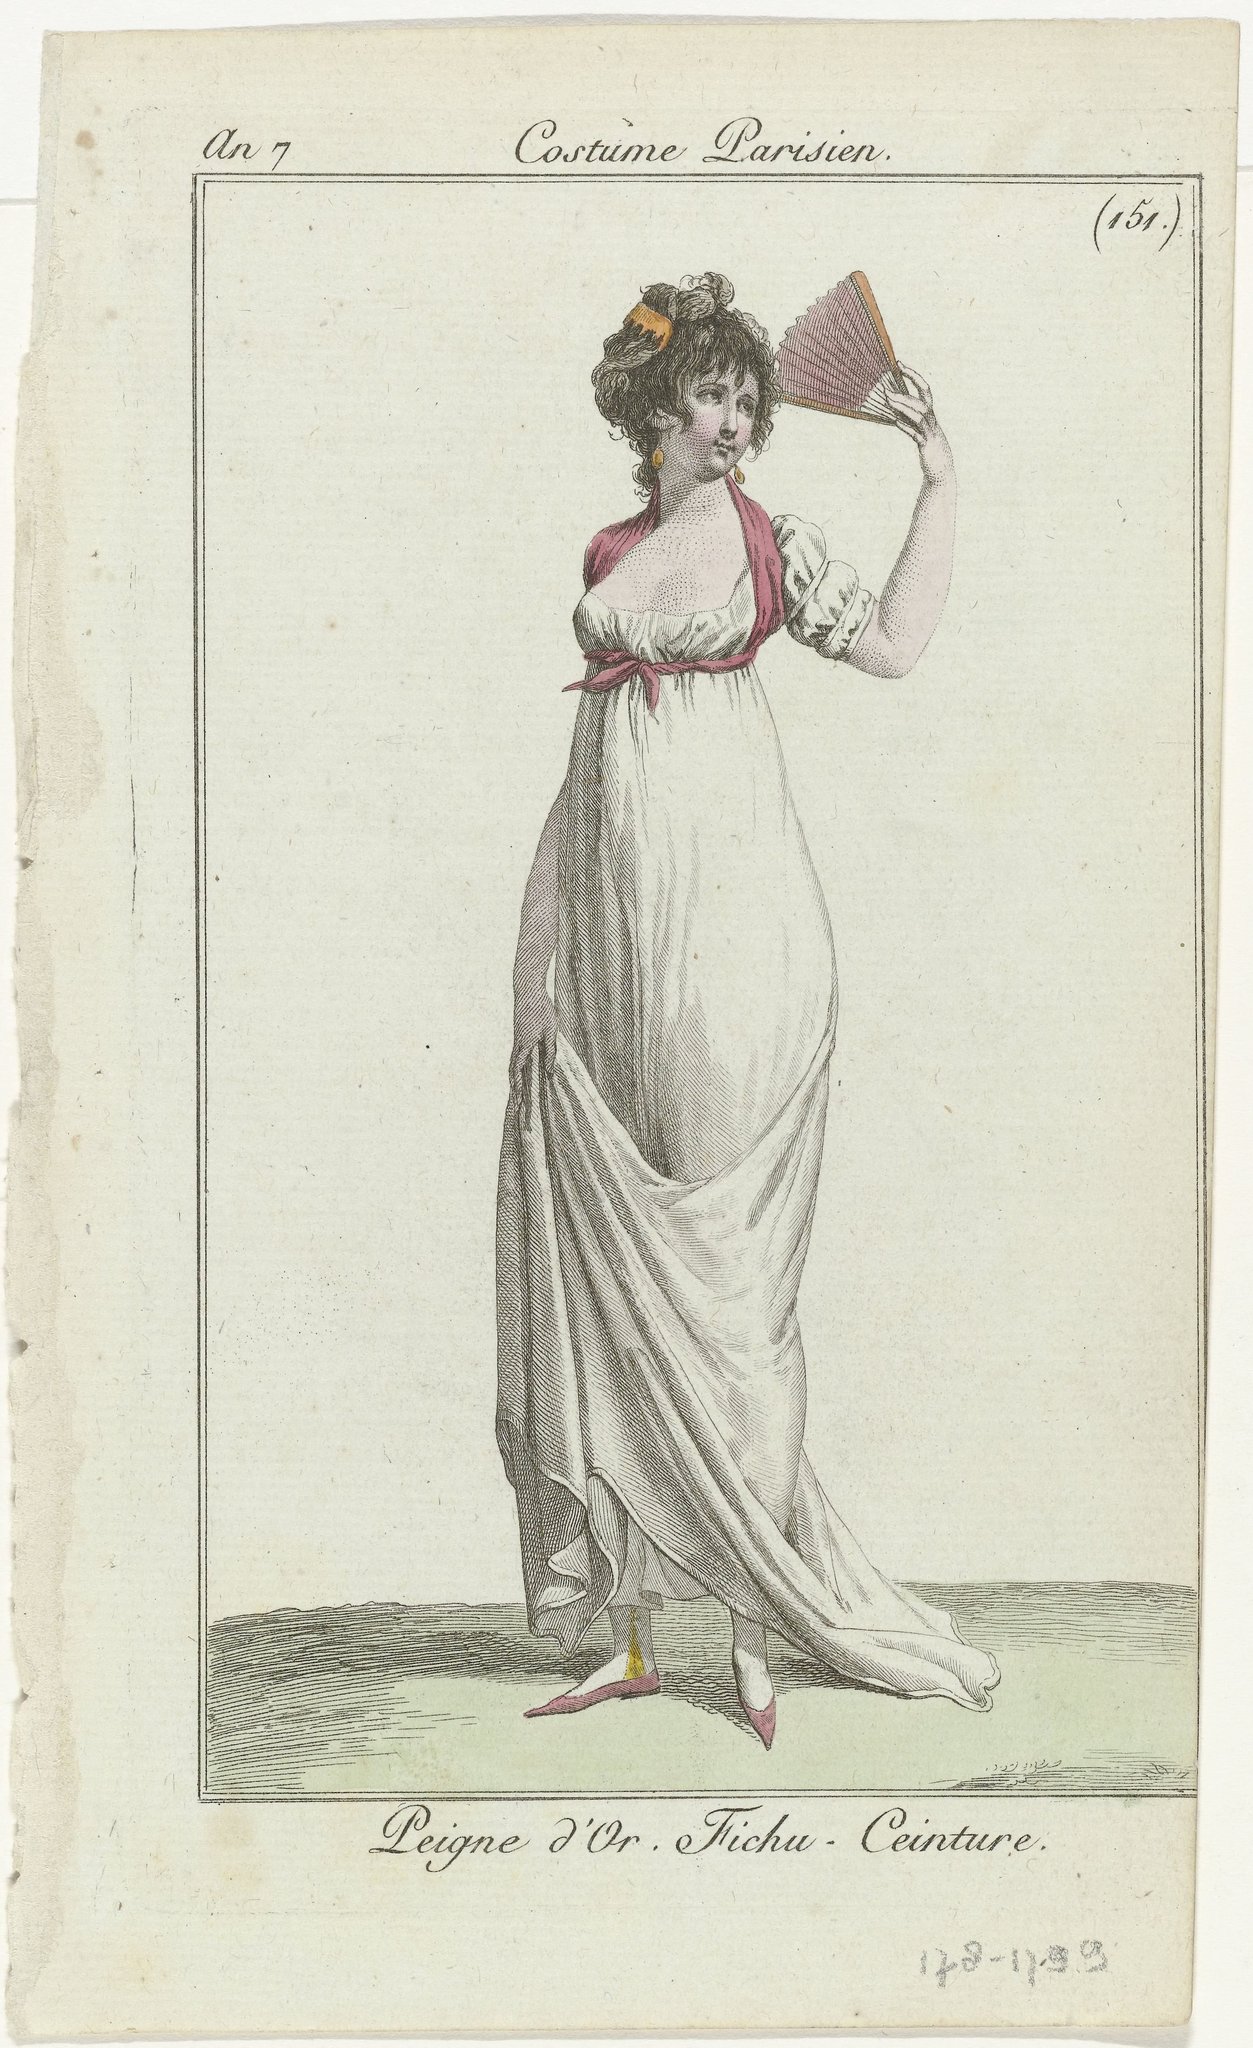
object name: fashion print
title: Journal des Dames et des Modes, Costume Parisien, 17 août 1799, An 7, (151.) : Peigne d'Or (...)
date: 1799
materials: paper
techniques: engraving, hand coloring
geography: paris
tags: ear-rings (+ women's clothes), underclothes for the lower part of the body (underskirt) (+ women's clothes), comb, brush and other tools (care of the hair) - aa - ~ women, fashion plates, shoes, sandals (+ women's clothes), dress, gown (+ women's clothes), stockings, socks (+ women's clothes), piece of clothing covering the breast or décolleté (fichu) (+ women's clothes), belt, girdle, waistband (+ women's clothes)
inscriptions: caption: ‘Peigne d'Or. Fichu-Ceinture.’, title: ‘Costume Parisien.’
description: Staande vrouw met in het opgestoken haar een haarkam van goud. Om de hals en taille een 'fichu - ceinture'. Zij draagt een japon met korte geplooide mouwen en sleep. Met de rechterhand houdt ze haar japon op, waardoor er een onderrok te zien is. Kousen met contrasterende klinken. Verdere accesssoires: oorbellen, vouwwaaier, platte schoenen met puntige neuzen. De prent maakt deel uit van het modetijdschrift Journal des Dames et des Modes, uitgegeven door Pierre de la Mésangère, Parijs, 1797-1839.